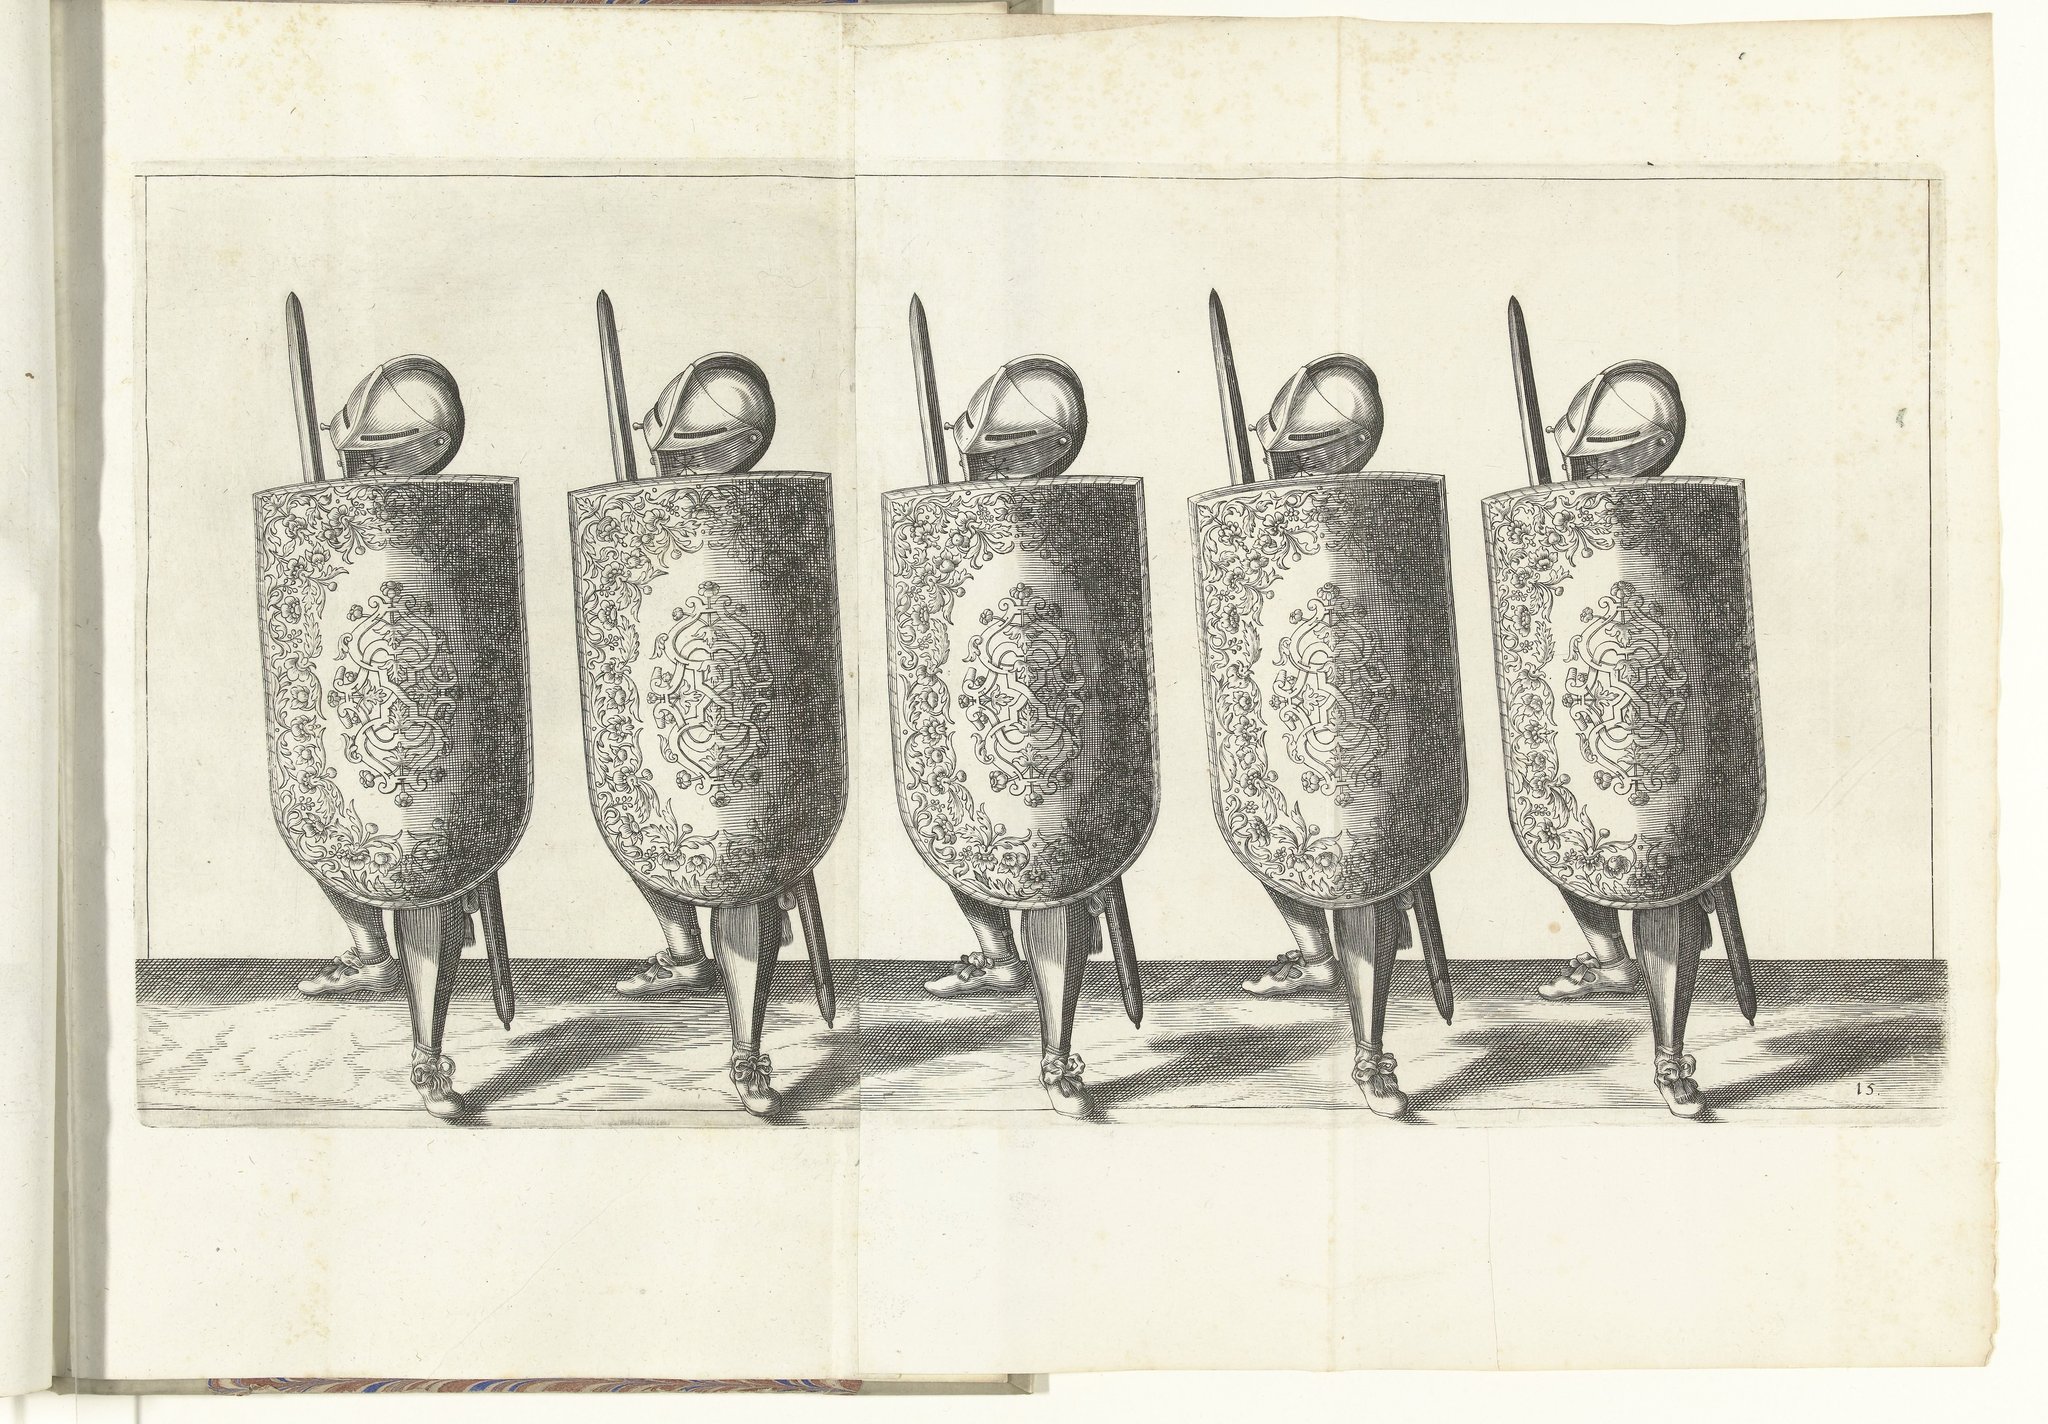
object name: print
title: De exercitie met de targe en rapier: vijf soldaten staande naast elkaar in het gelid met de targe en rapier voor de borst en de linkervoet naar voren, (nr. 15), 1618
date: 1616-1618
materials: paper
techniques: engraving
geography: northern netherlands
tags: maurice (prince of orange), handling of weapons ~ military training, weapons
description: De exercitie met de targe en rapier: vijf soldaten staande naast elkaar in het gelid met de targe en rapier voor de borst en de linkervoet naar voren, 1618. Grote prent van twee aan elkaar geplakte bladen. Onderdeel van de illustraties in: Adam van Breen, De Nassausche Wapen-Handelinge: Korte Onderwijsinge op de figuerlijcke af-beeldinghe belangende 'trecht ghebruyck van al 'tghene een Soldaet noodigh is in het handelen vande Targes met het Rappier, 1618, plaat nr. 15. Krijgswezen rond 1600.